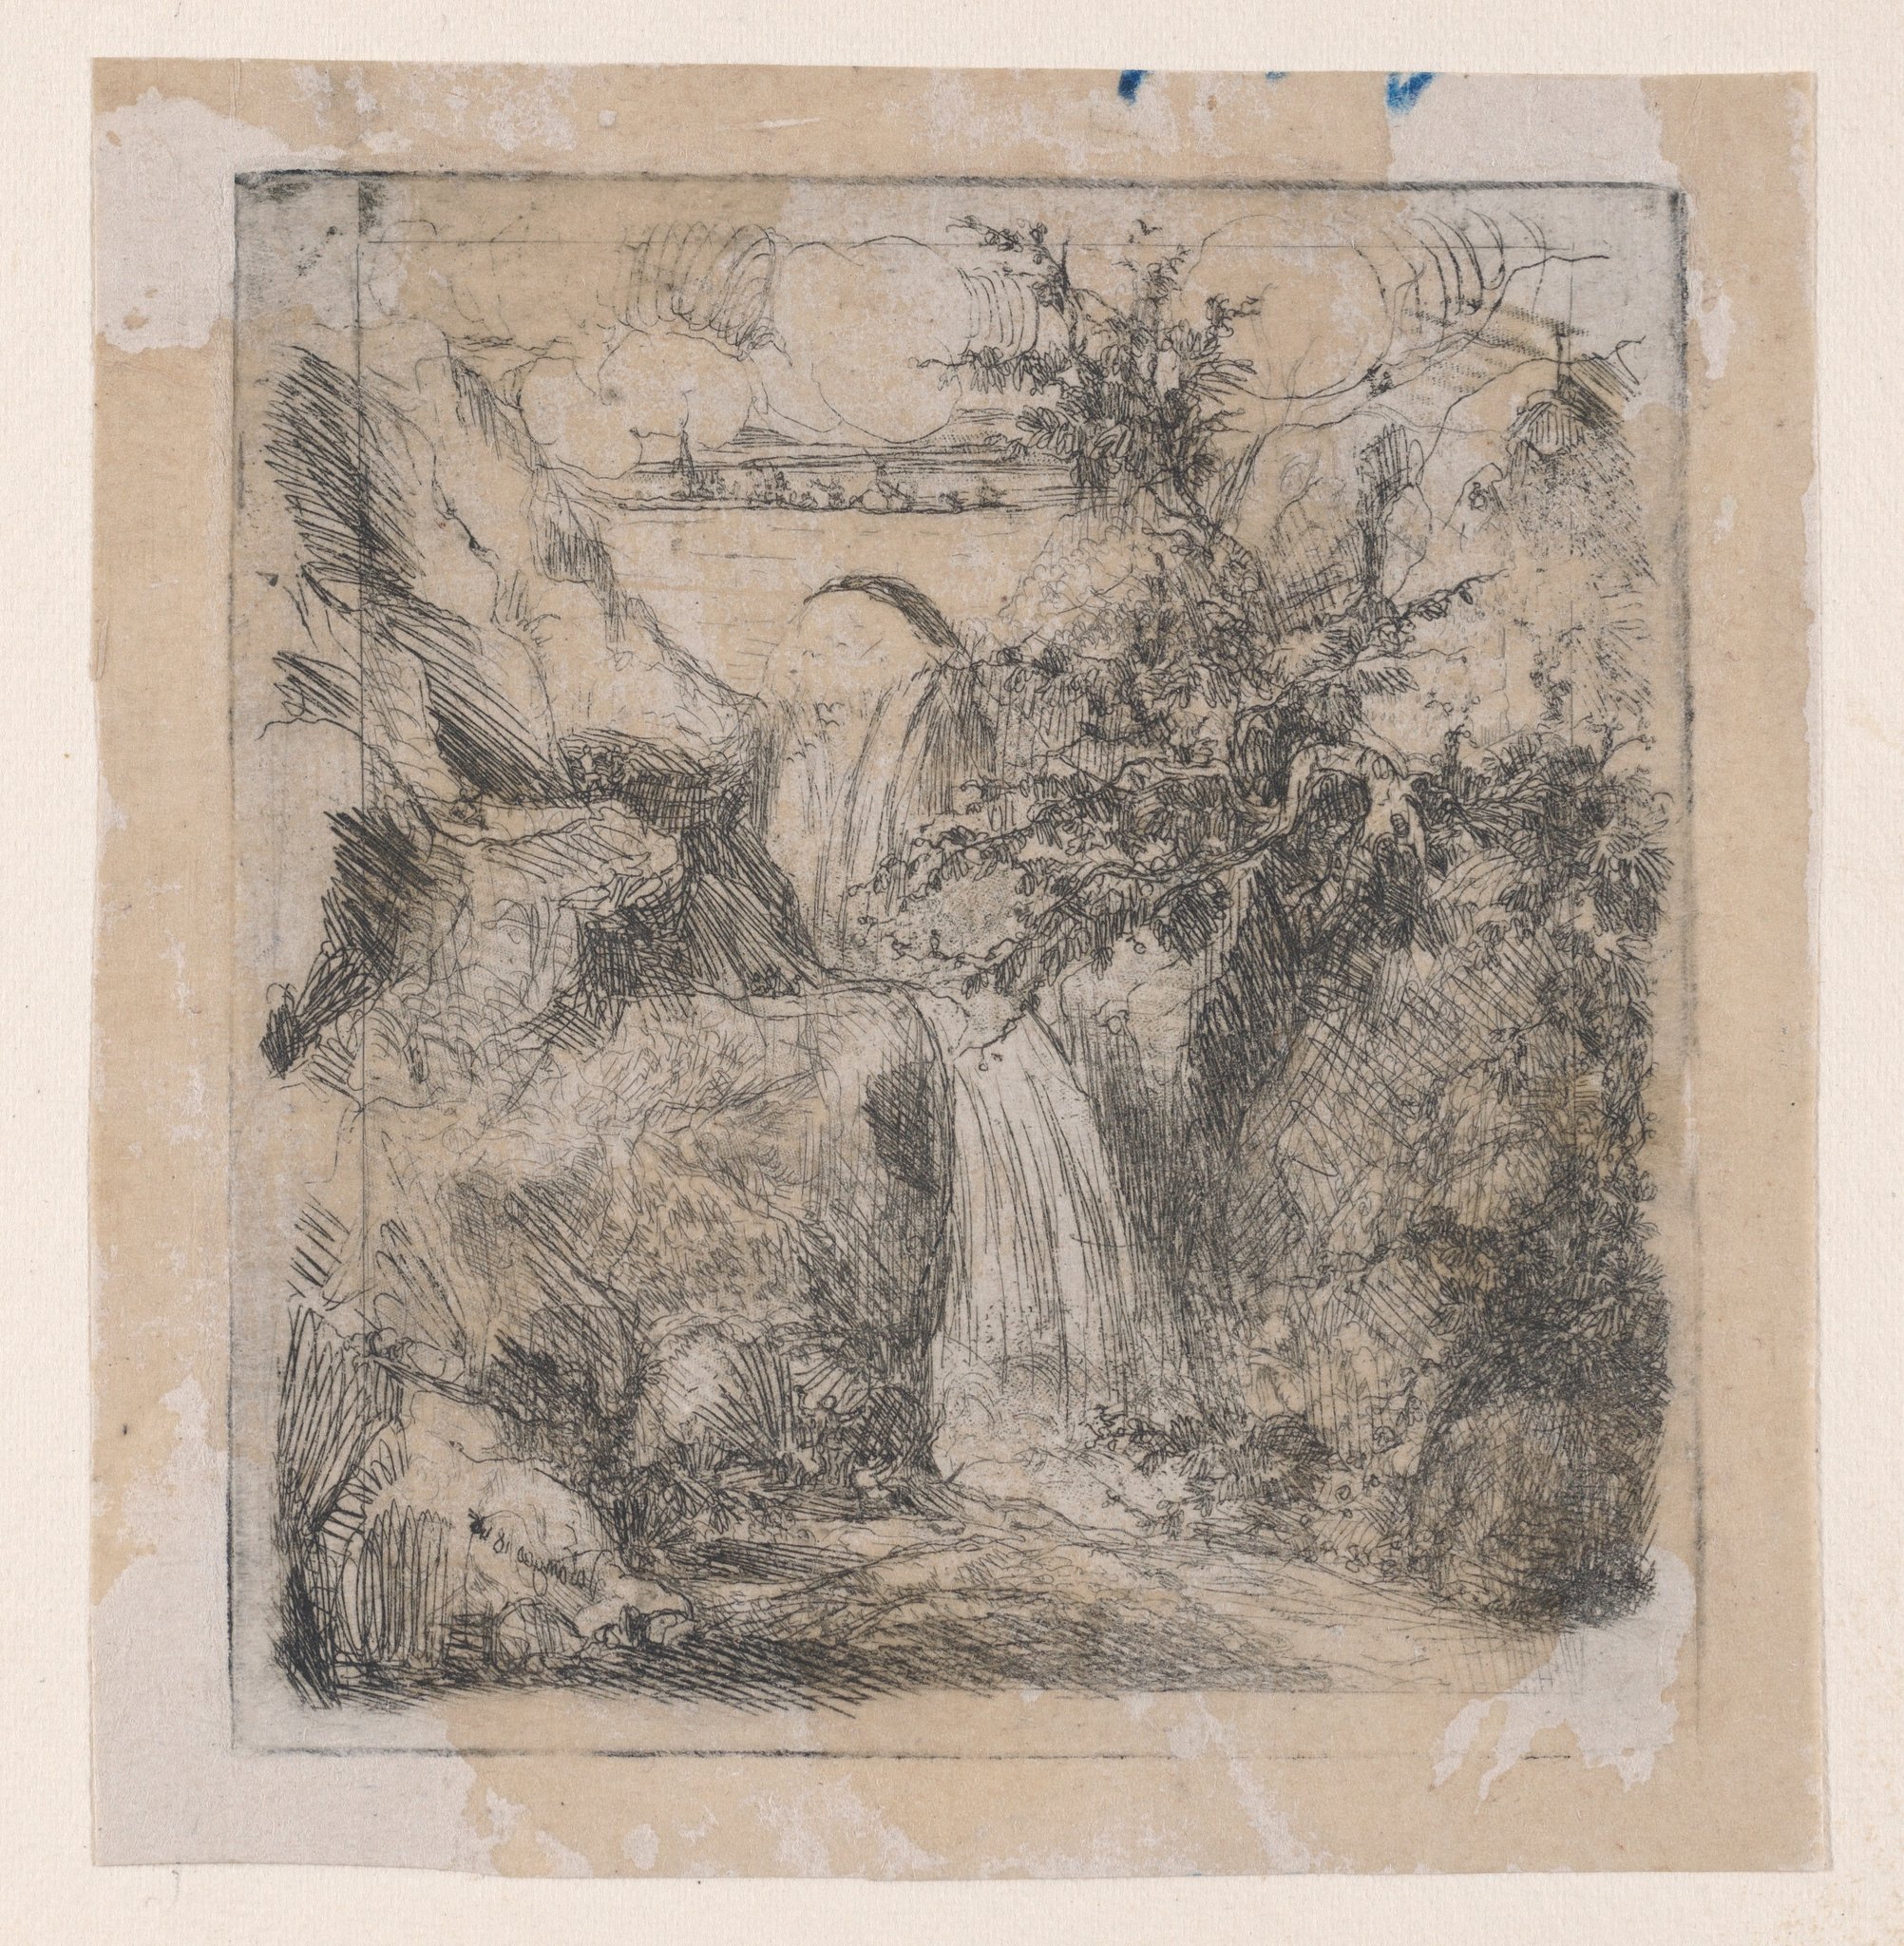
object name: print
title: Les Cascades (The Waterfalls)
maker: rodolphe bresdin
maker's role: artist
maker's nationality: french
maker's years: 1822-1885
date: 1845-1846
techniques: etching